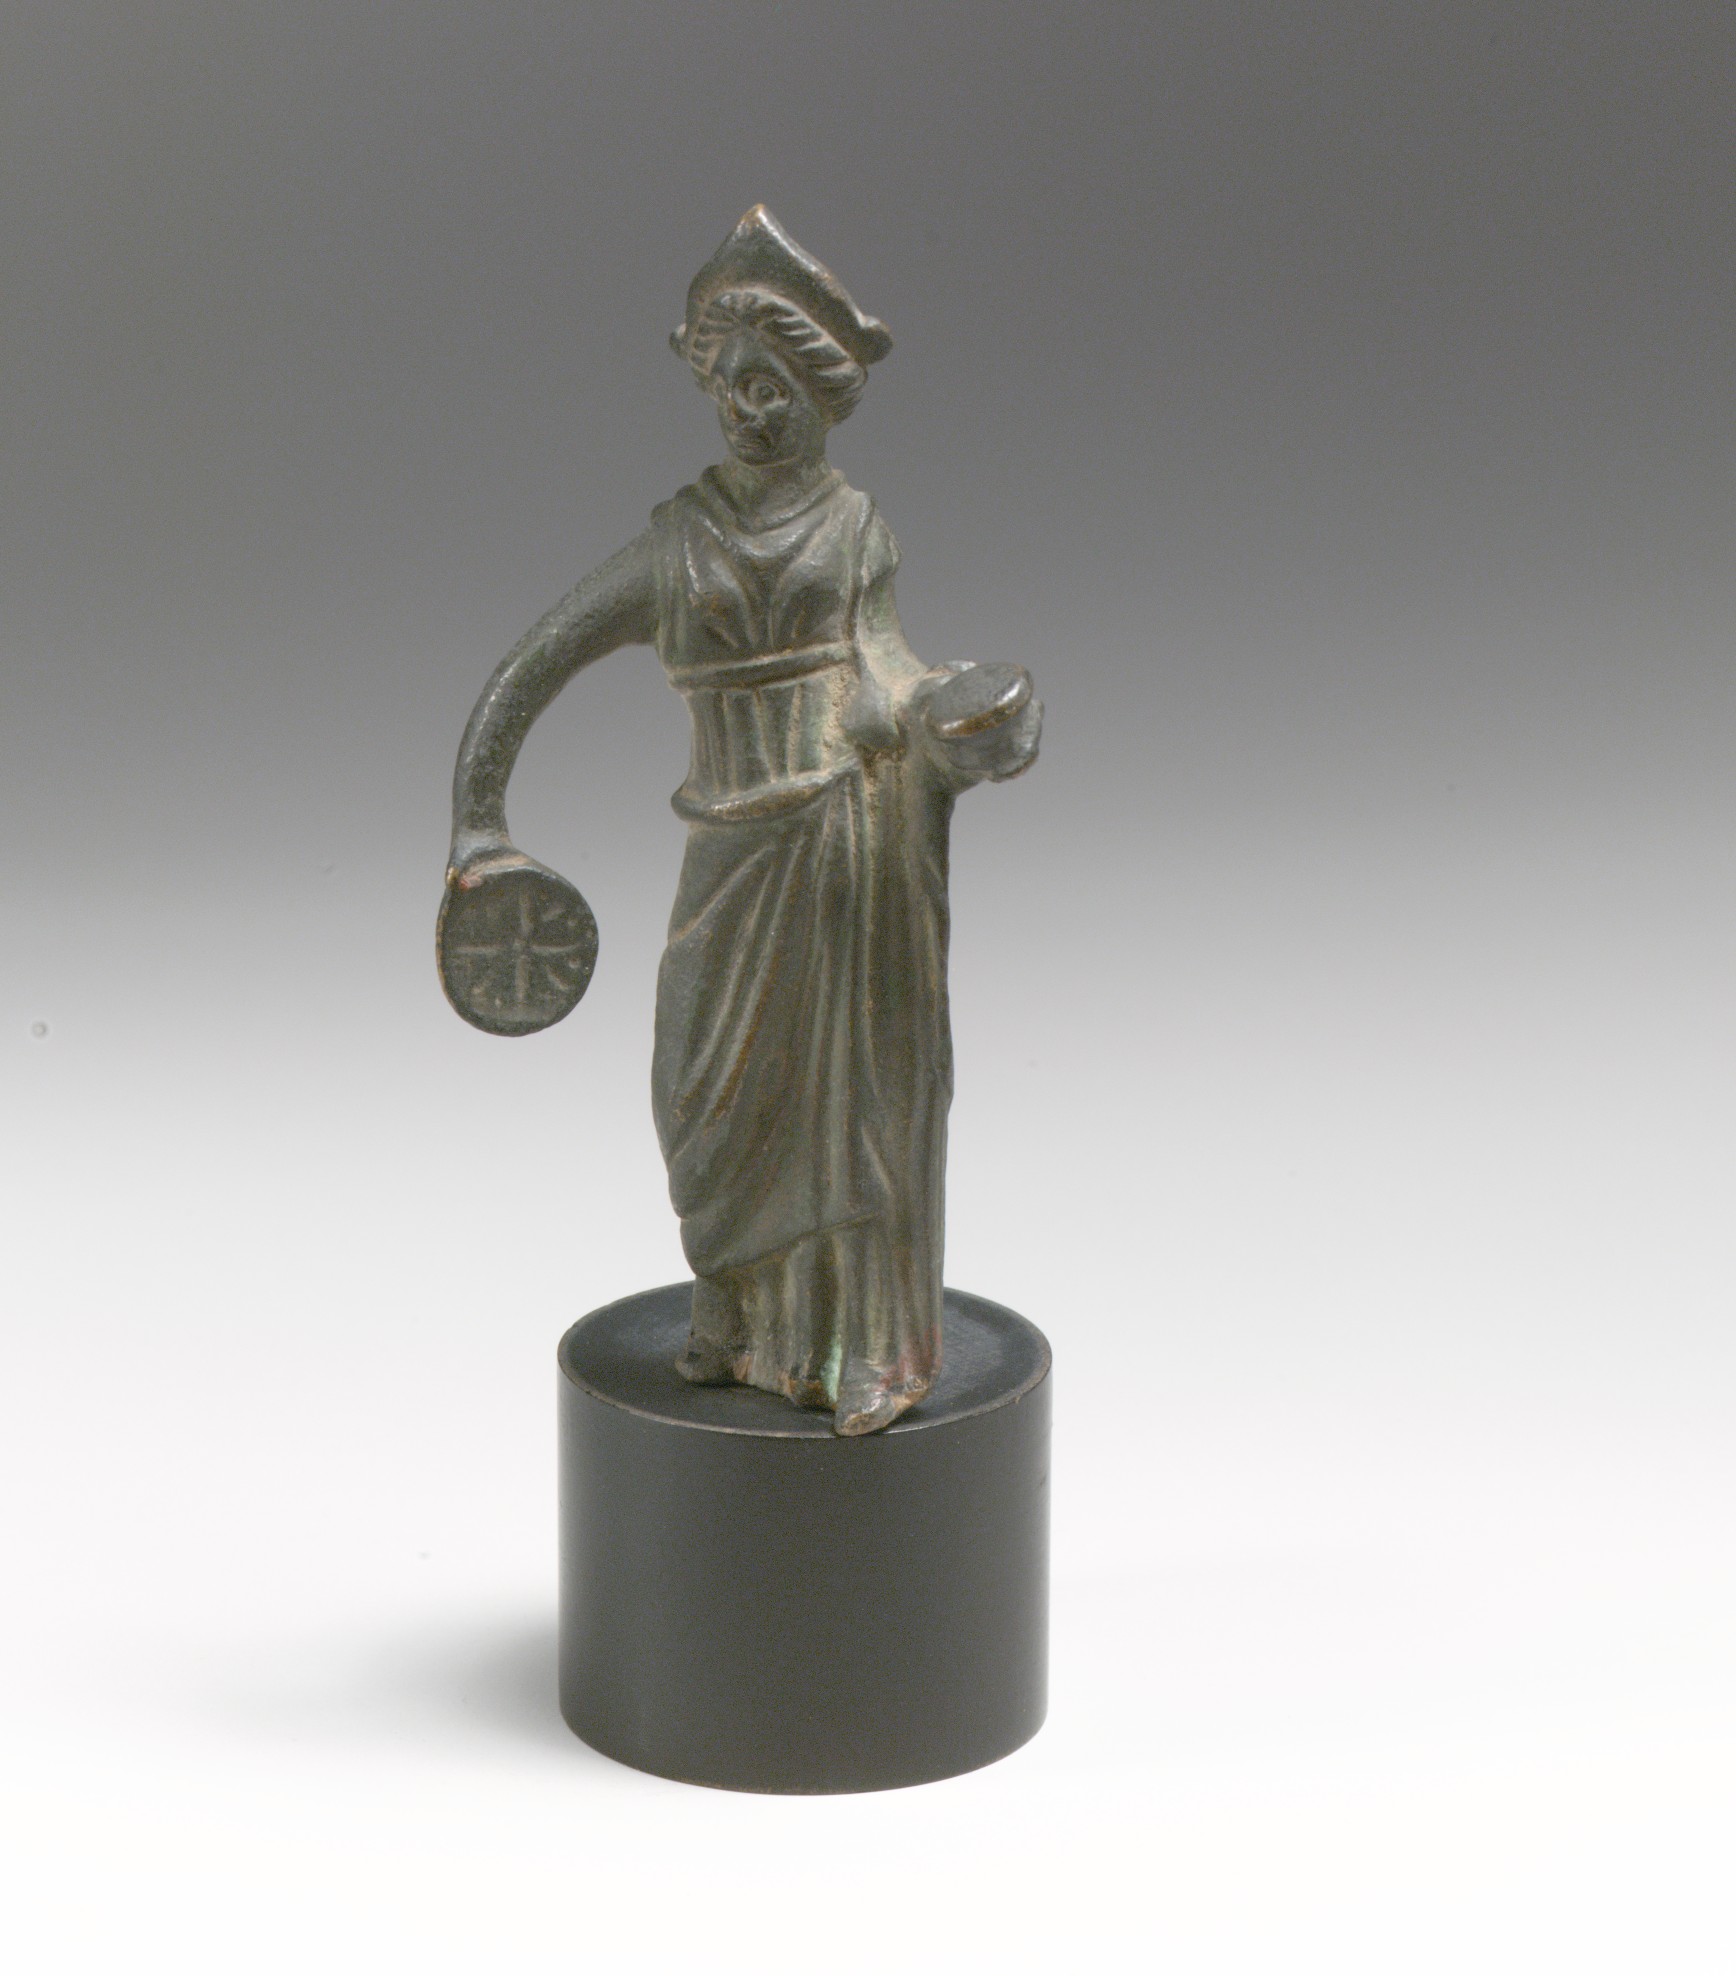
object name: statuette of a woman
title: Bronze statuette of a goddess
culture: italic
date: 300-1 BCE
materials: bronze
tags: goddess